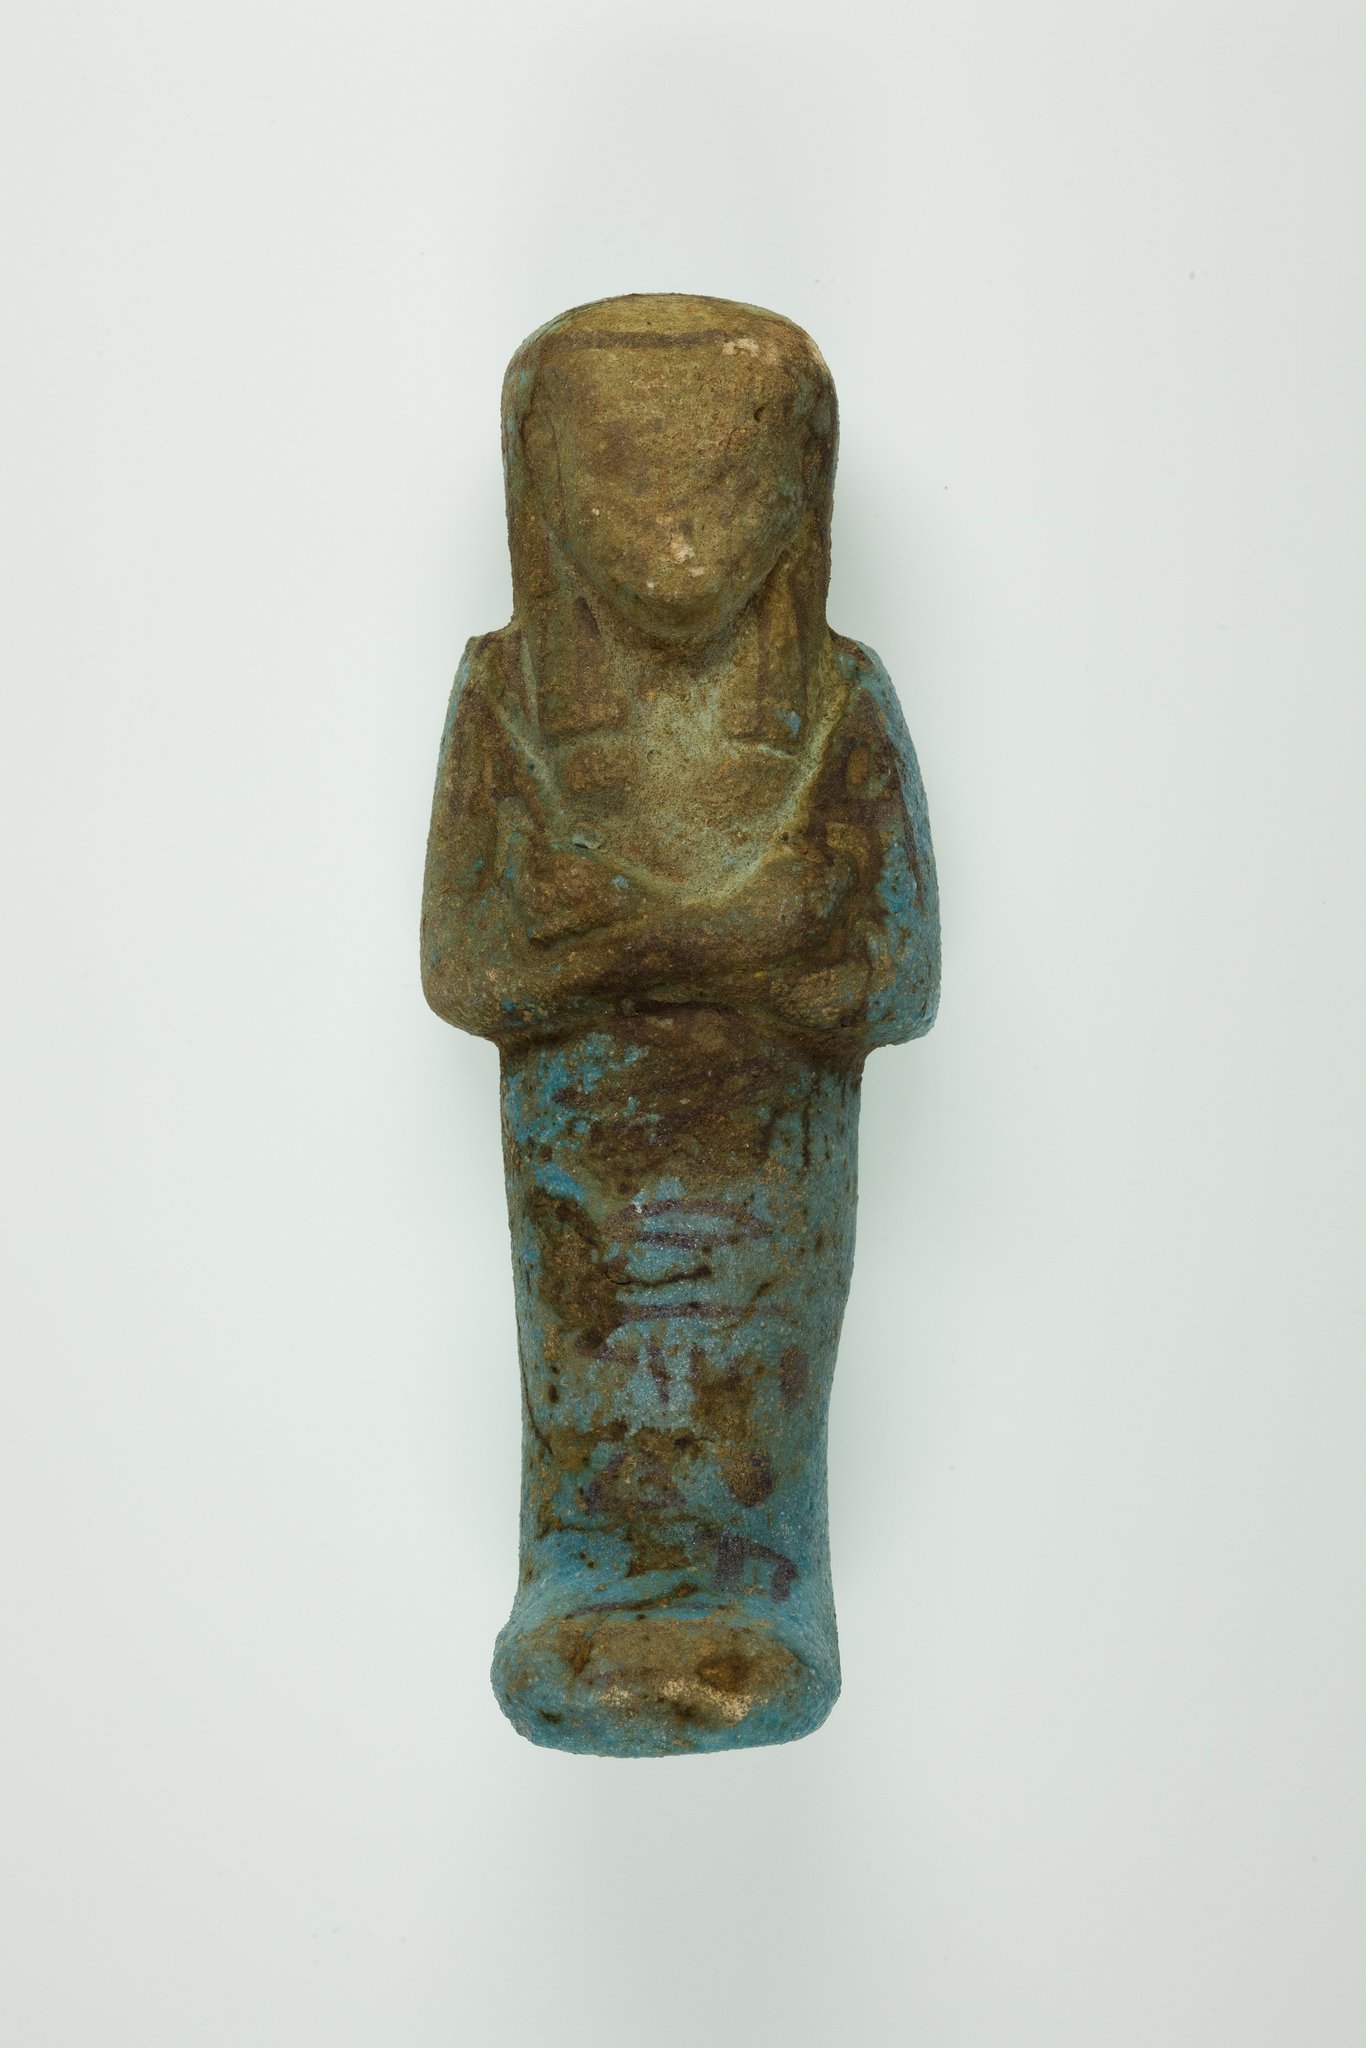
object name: shabti, henettawy c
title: Worker Shabti of Henettawy (C), Daughter of Isetemkheb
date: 990-970 BCE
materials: faience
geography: egypt